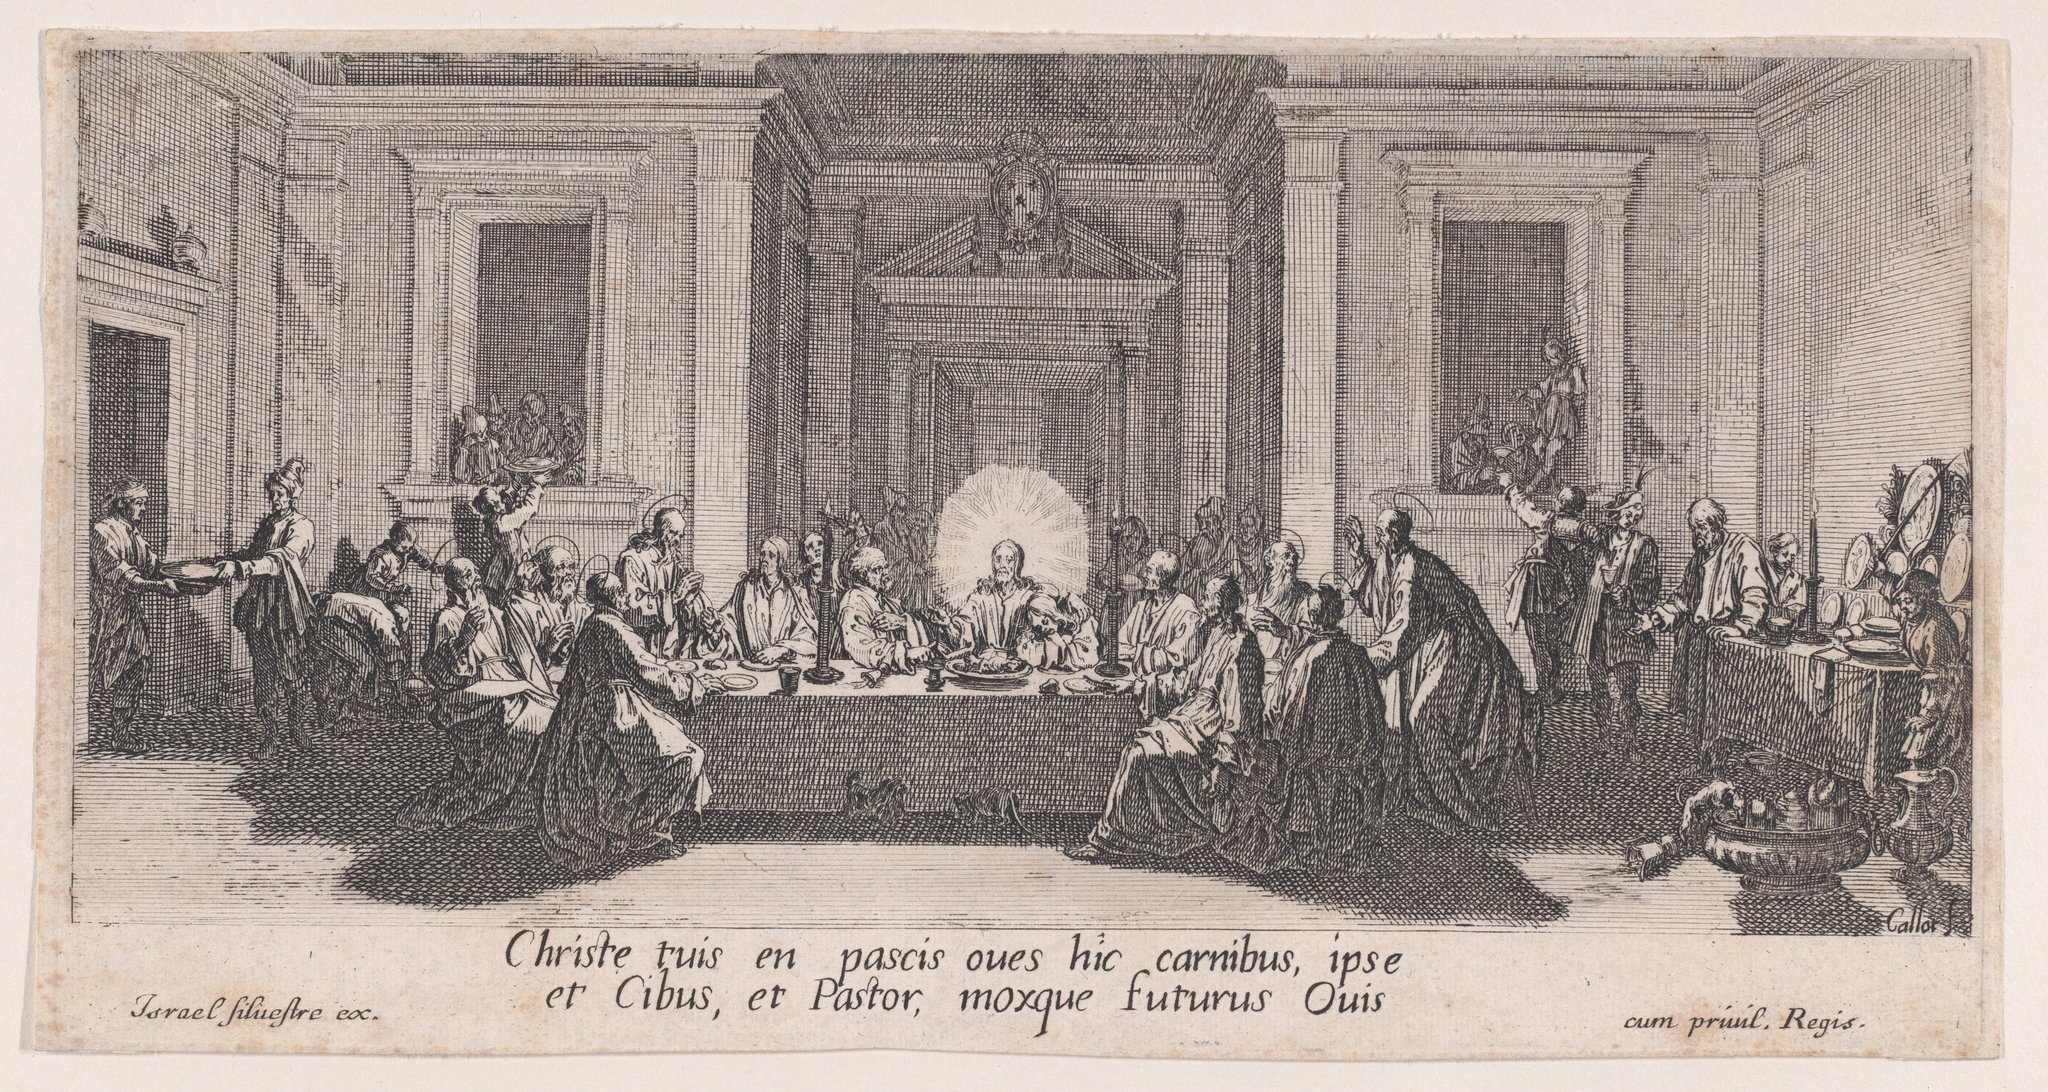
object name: print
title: La Cêne (The Last Supper), from "La Grande Passion" (The Large Passion)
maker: jacques callot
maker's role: artist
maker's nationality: french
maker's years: 1592-1635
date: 1619-1624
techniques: engraving, etching